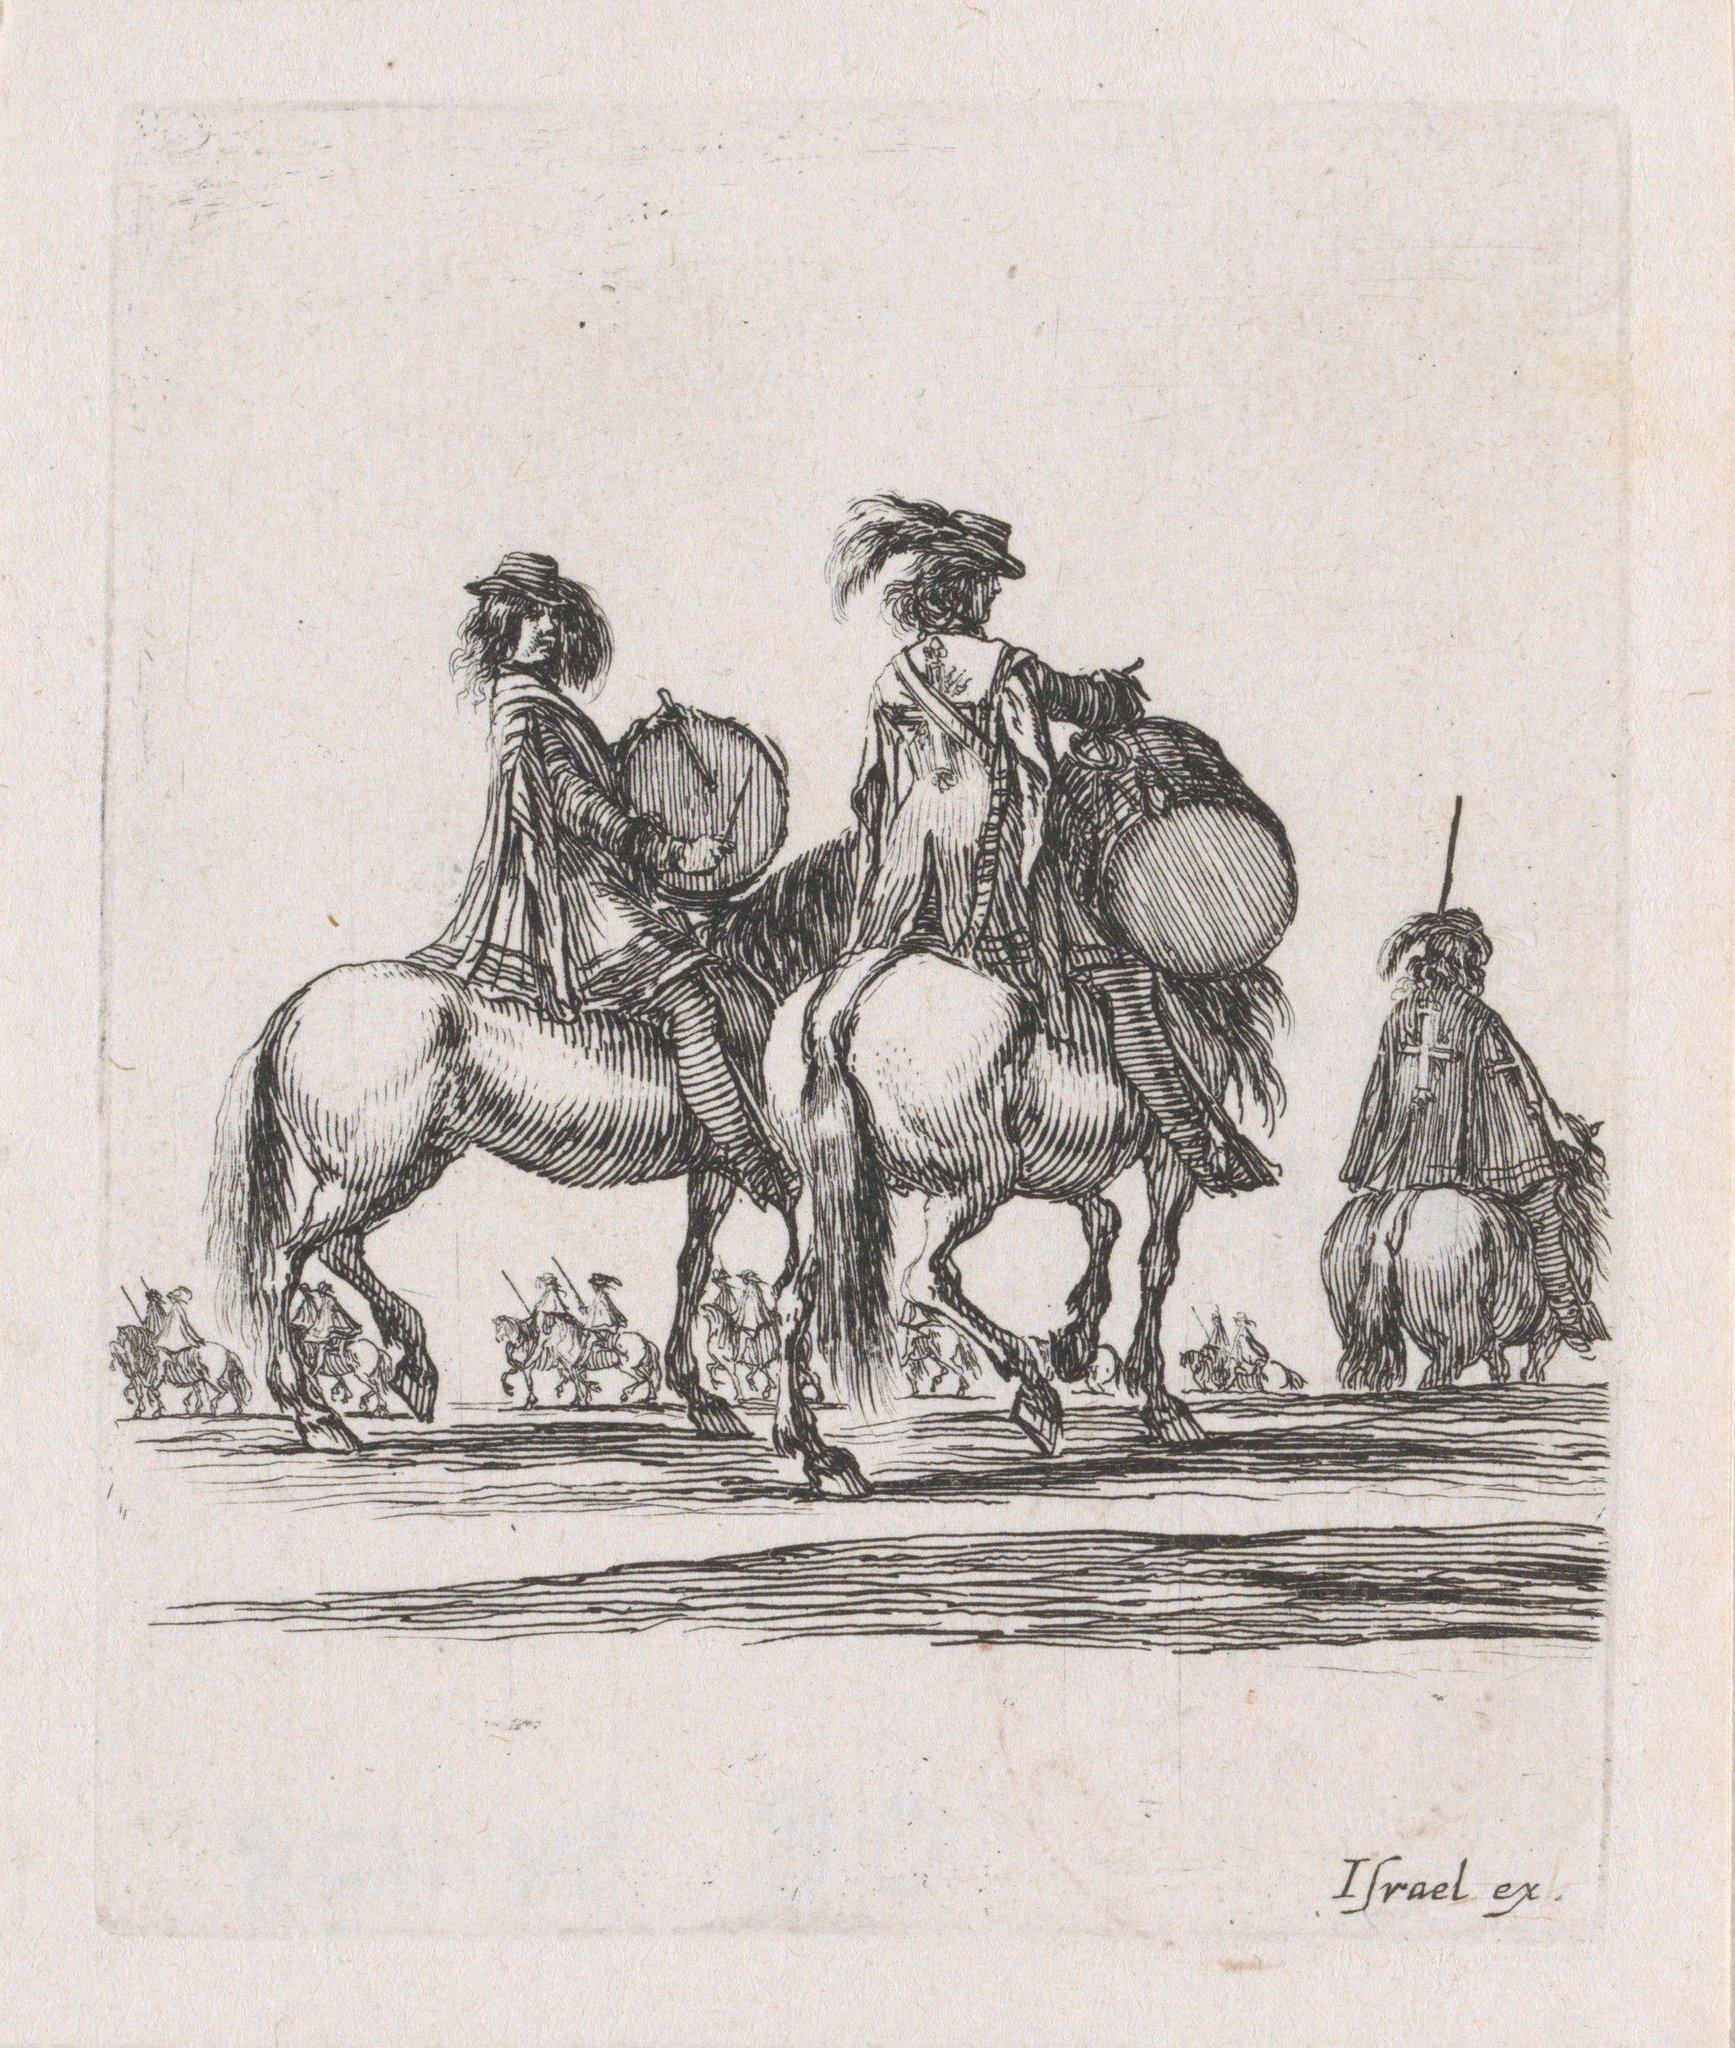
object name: print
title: Twee trommelaars te paard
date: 1620-1664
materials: paper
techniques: etching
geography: france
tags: riding a horse, ass, or mule; rider, horseman, military band, warfare; military affairs (+ cavalry, horsemen), the soldier; the soldier's life, horse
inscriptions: collector's mark: Lugt 240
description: Prent uit een reeks van 19 prenten. Getekende voorstudie wordt bewaard in de Biblioteca Marucelliana te Florence (inv. nr. Vol. D, N. 56).